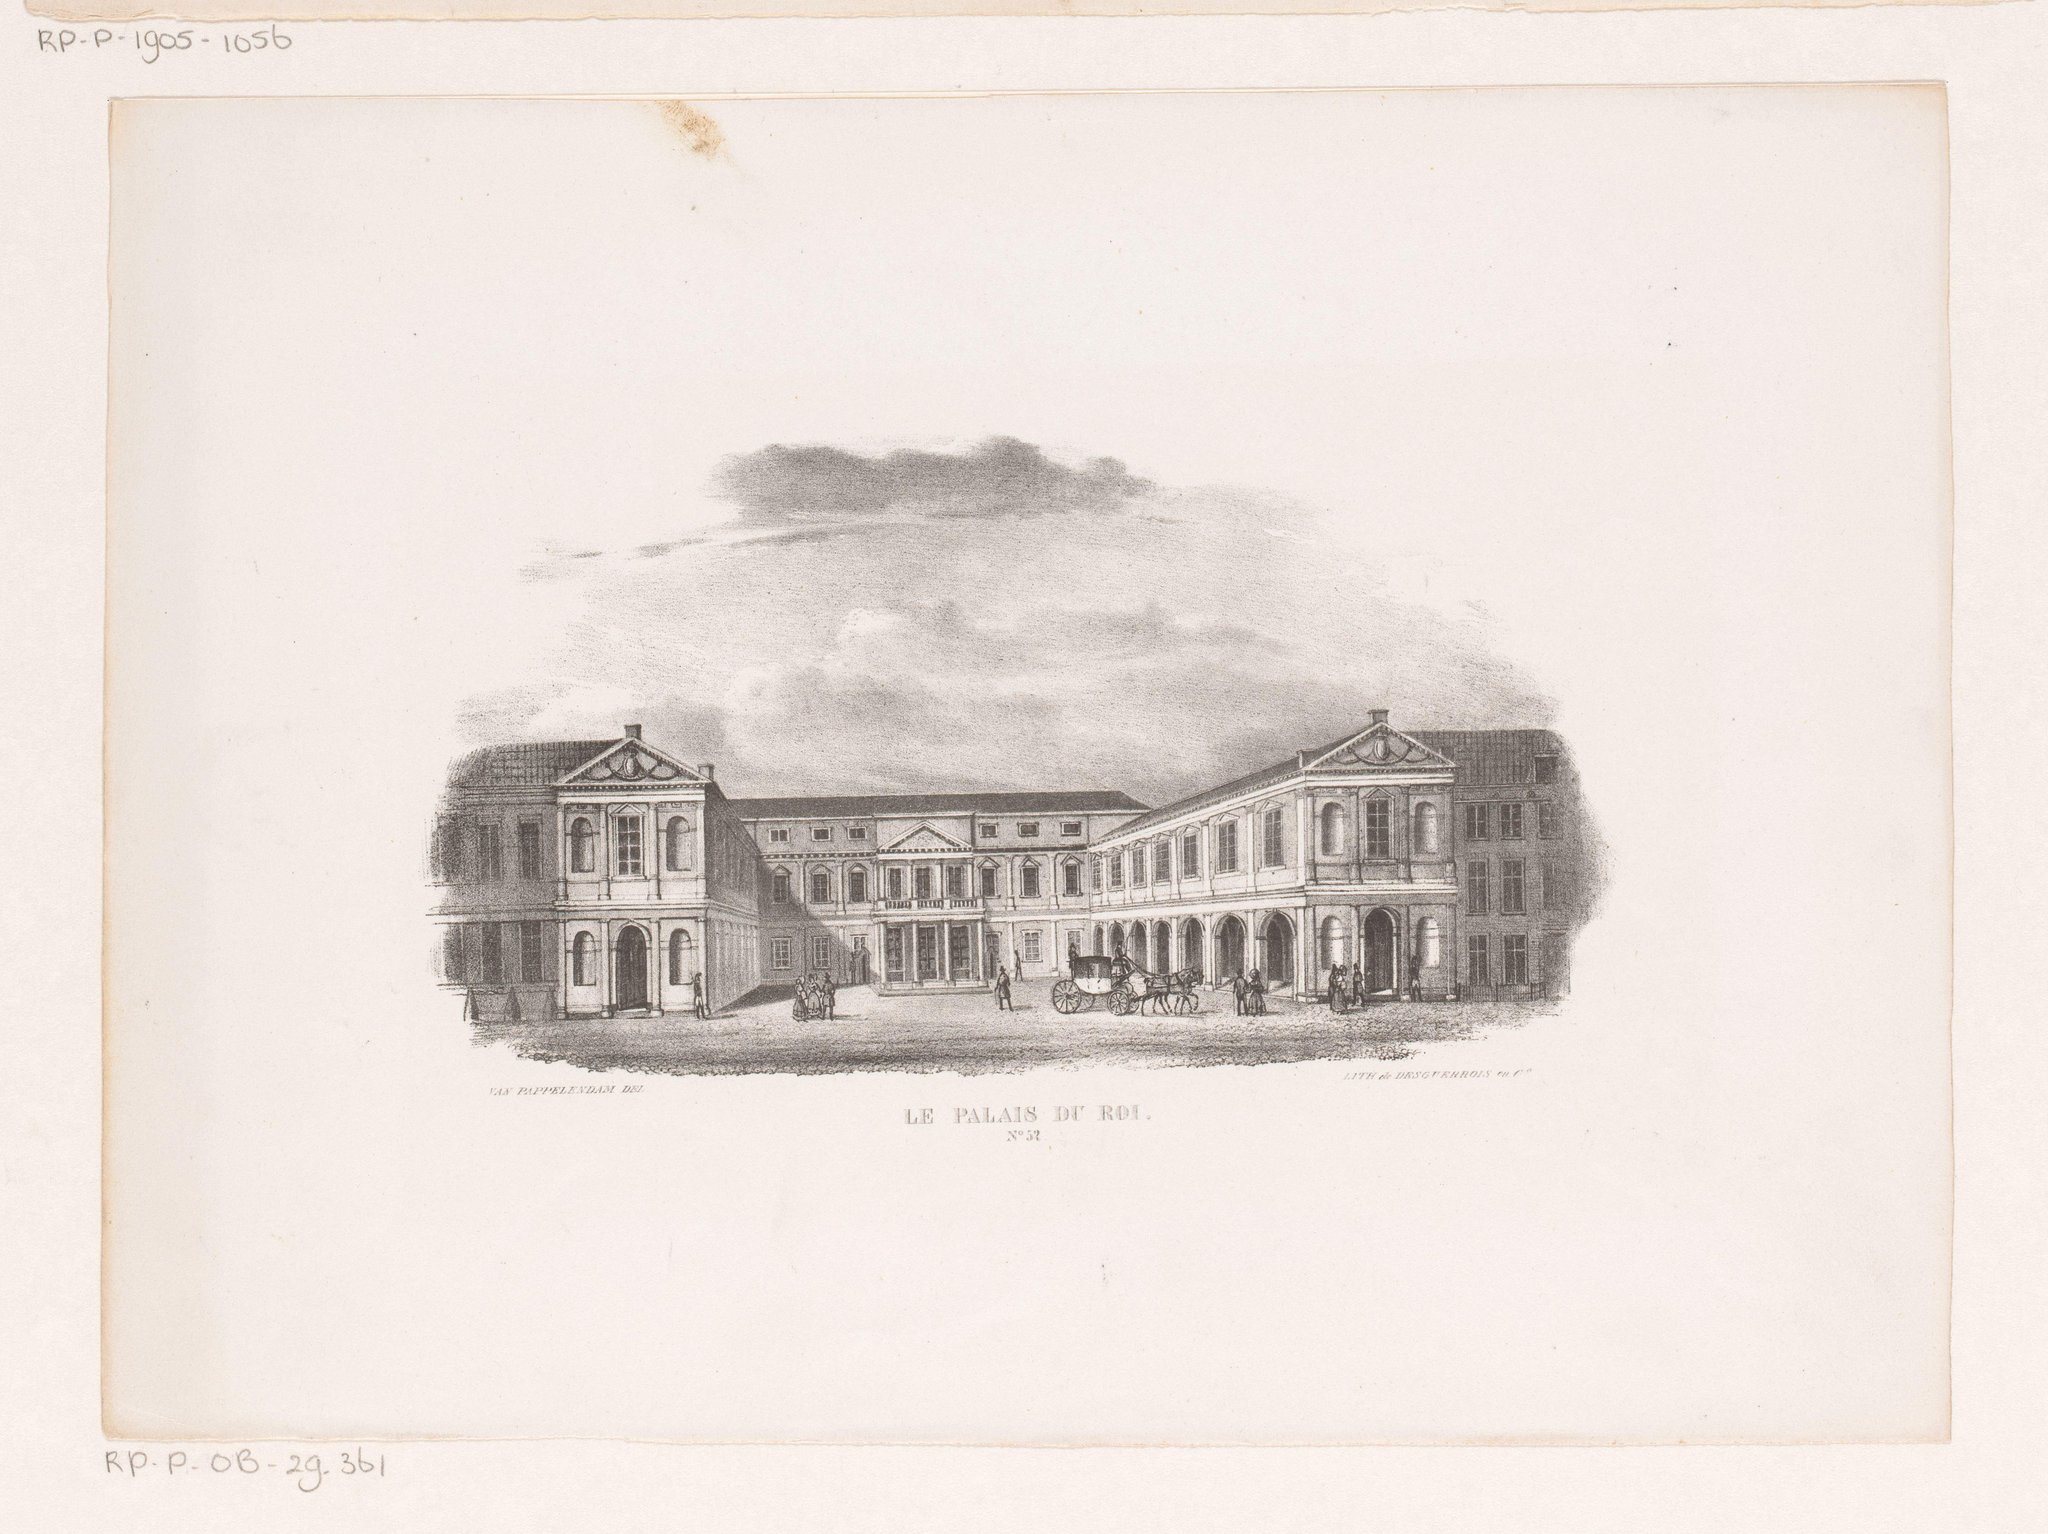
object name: print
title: Le palais du roi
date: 1827-1884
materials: paper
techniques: lithograph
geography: amsterdam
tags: palace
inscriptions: collector's mark: Lugt 2228